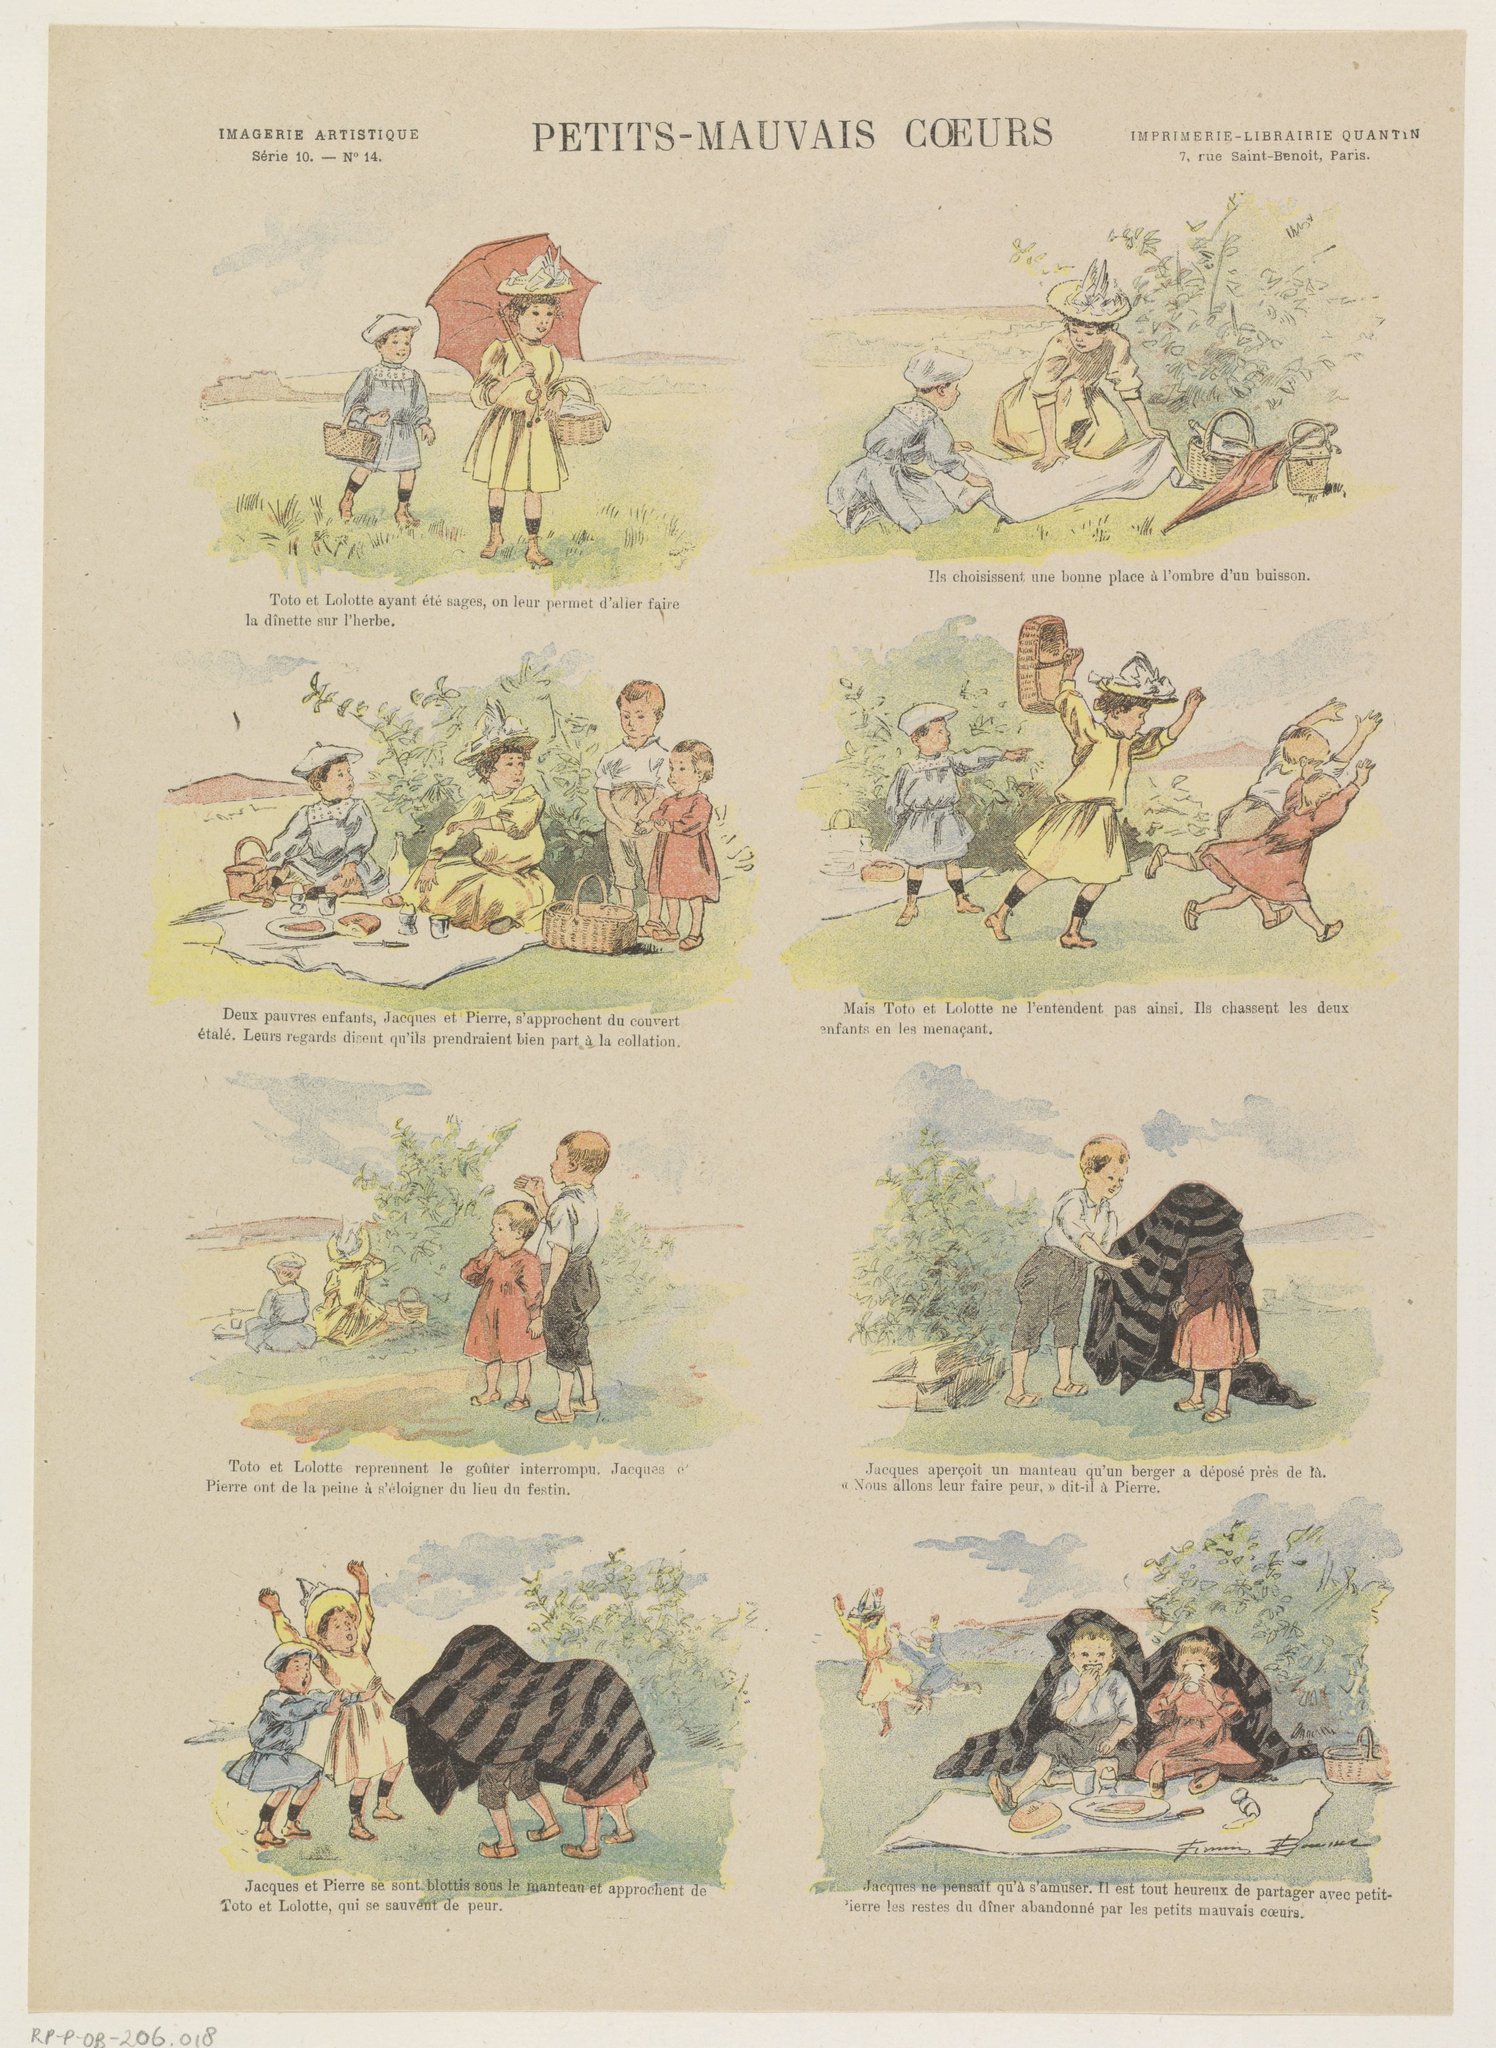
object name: print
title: Imagerie Artistique / Série 10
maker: albert quantin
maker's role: printer, publisher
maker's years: 1850-1933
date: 1876-1890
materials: paper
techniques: lithograph, letterpress printing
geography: paris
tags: picnic, alfresco, 'déjeuner sur l'herbe', tales and fairy tales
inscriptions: collector's mark: Lugt 2760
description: Blad met 8 voorstellingen van kinderen die picknicken. Onder elke afbeelding een onderschrift in het Frans. Genummerd linksboven: Série 10. - No. 14.